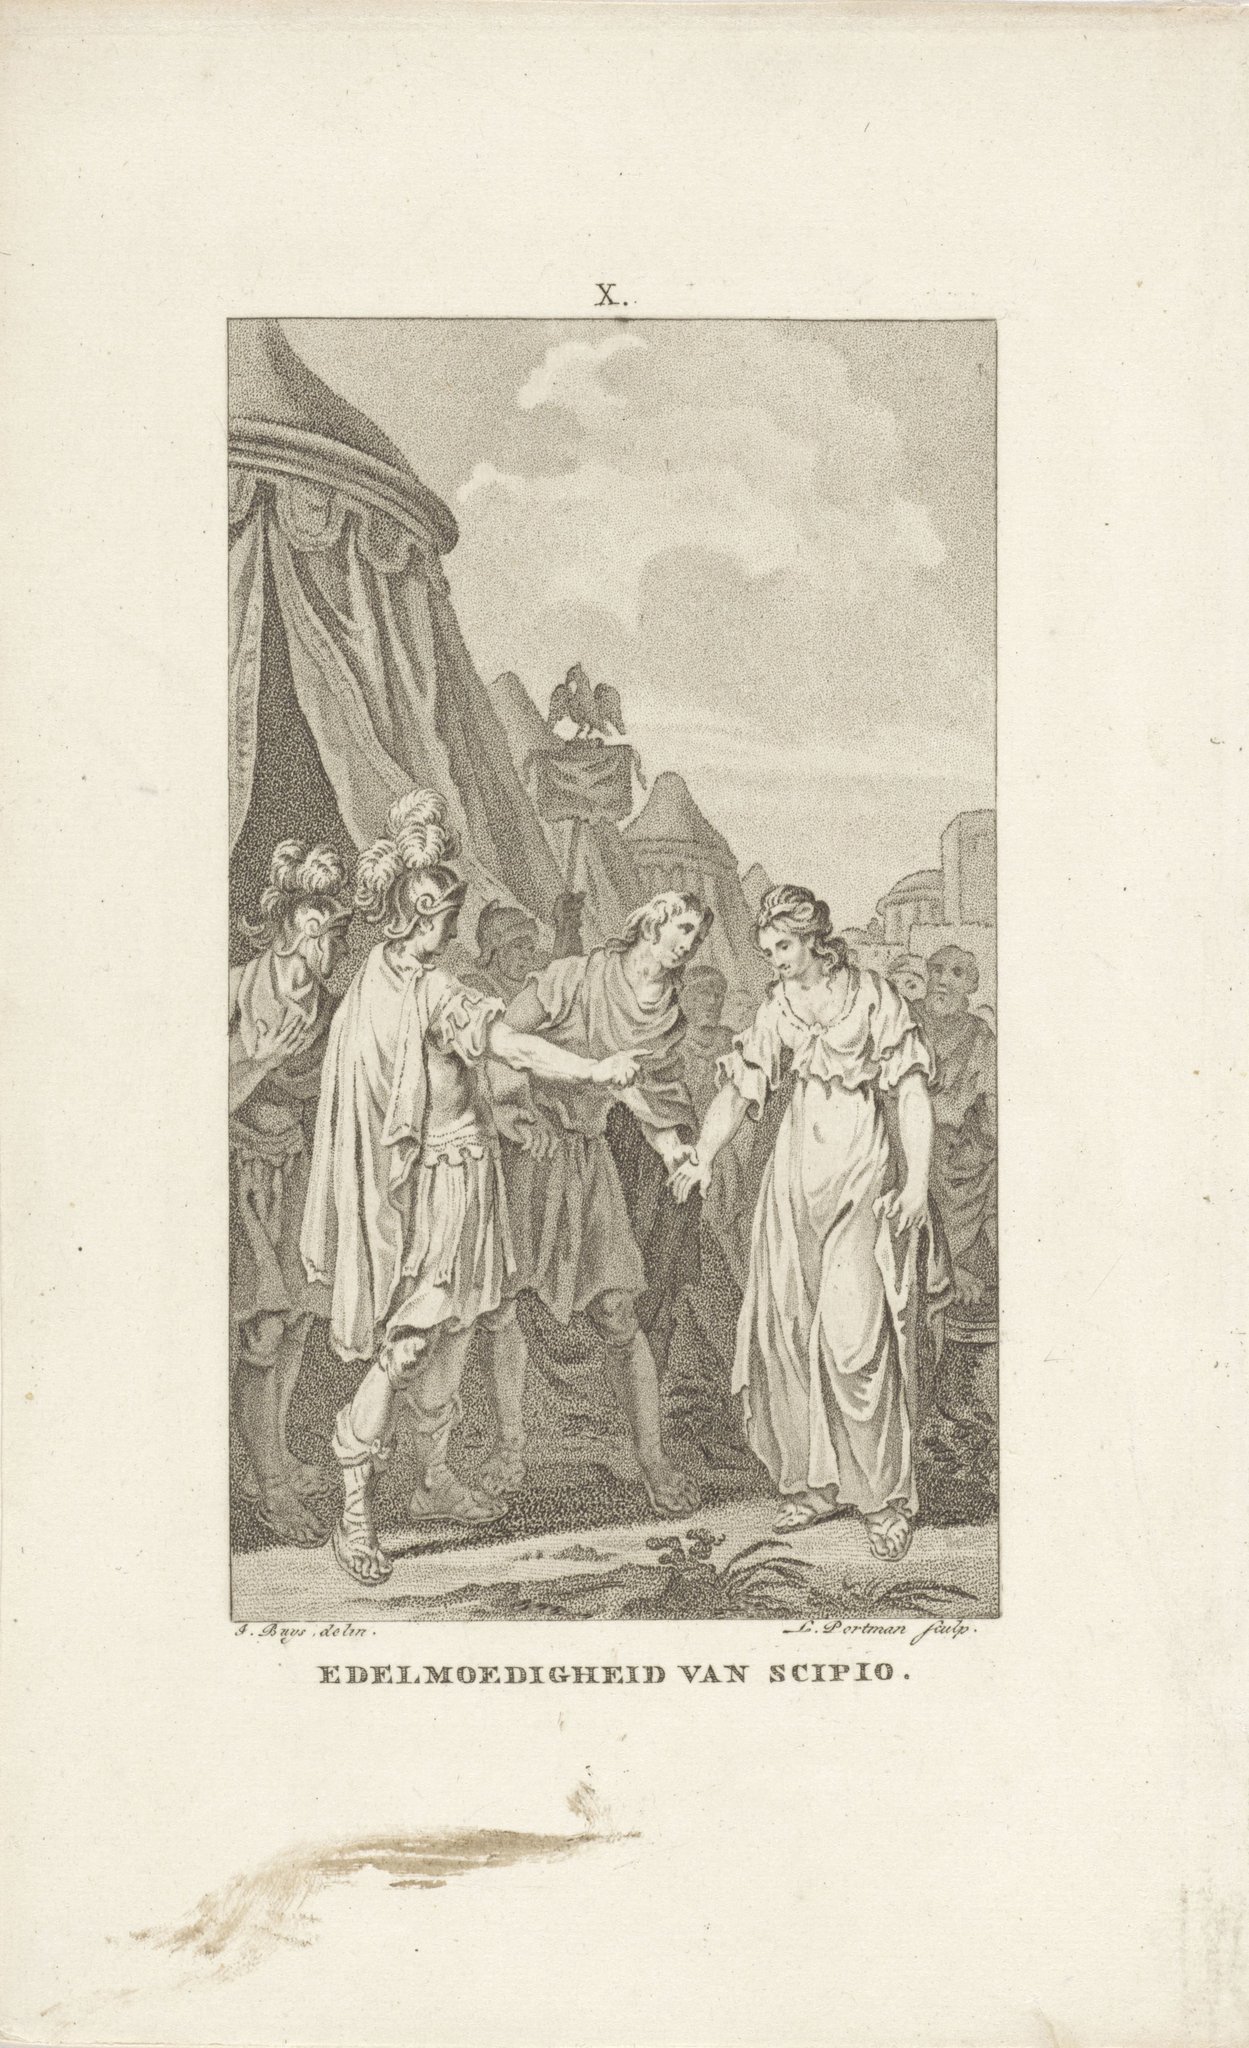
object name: print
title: Edelmoedigheid van Scipio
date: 1795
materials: paper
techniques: stippled etching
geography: amsterdam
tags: the continence of scipio: he restores a captive woman to her bridegroom allucius, who kneels before him; the ransom offered by the bride's parents is given to allucius as a wedding-gift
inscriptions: collector's mark: Lugt 2228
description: Allucius wordt door Publius Cornelius Scipio Africanus herenigd met zijn verloofde. Uit dankbaarheid grijpt hij de hand van de Romeinse generaal.